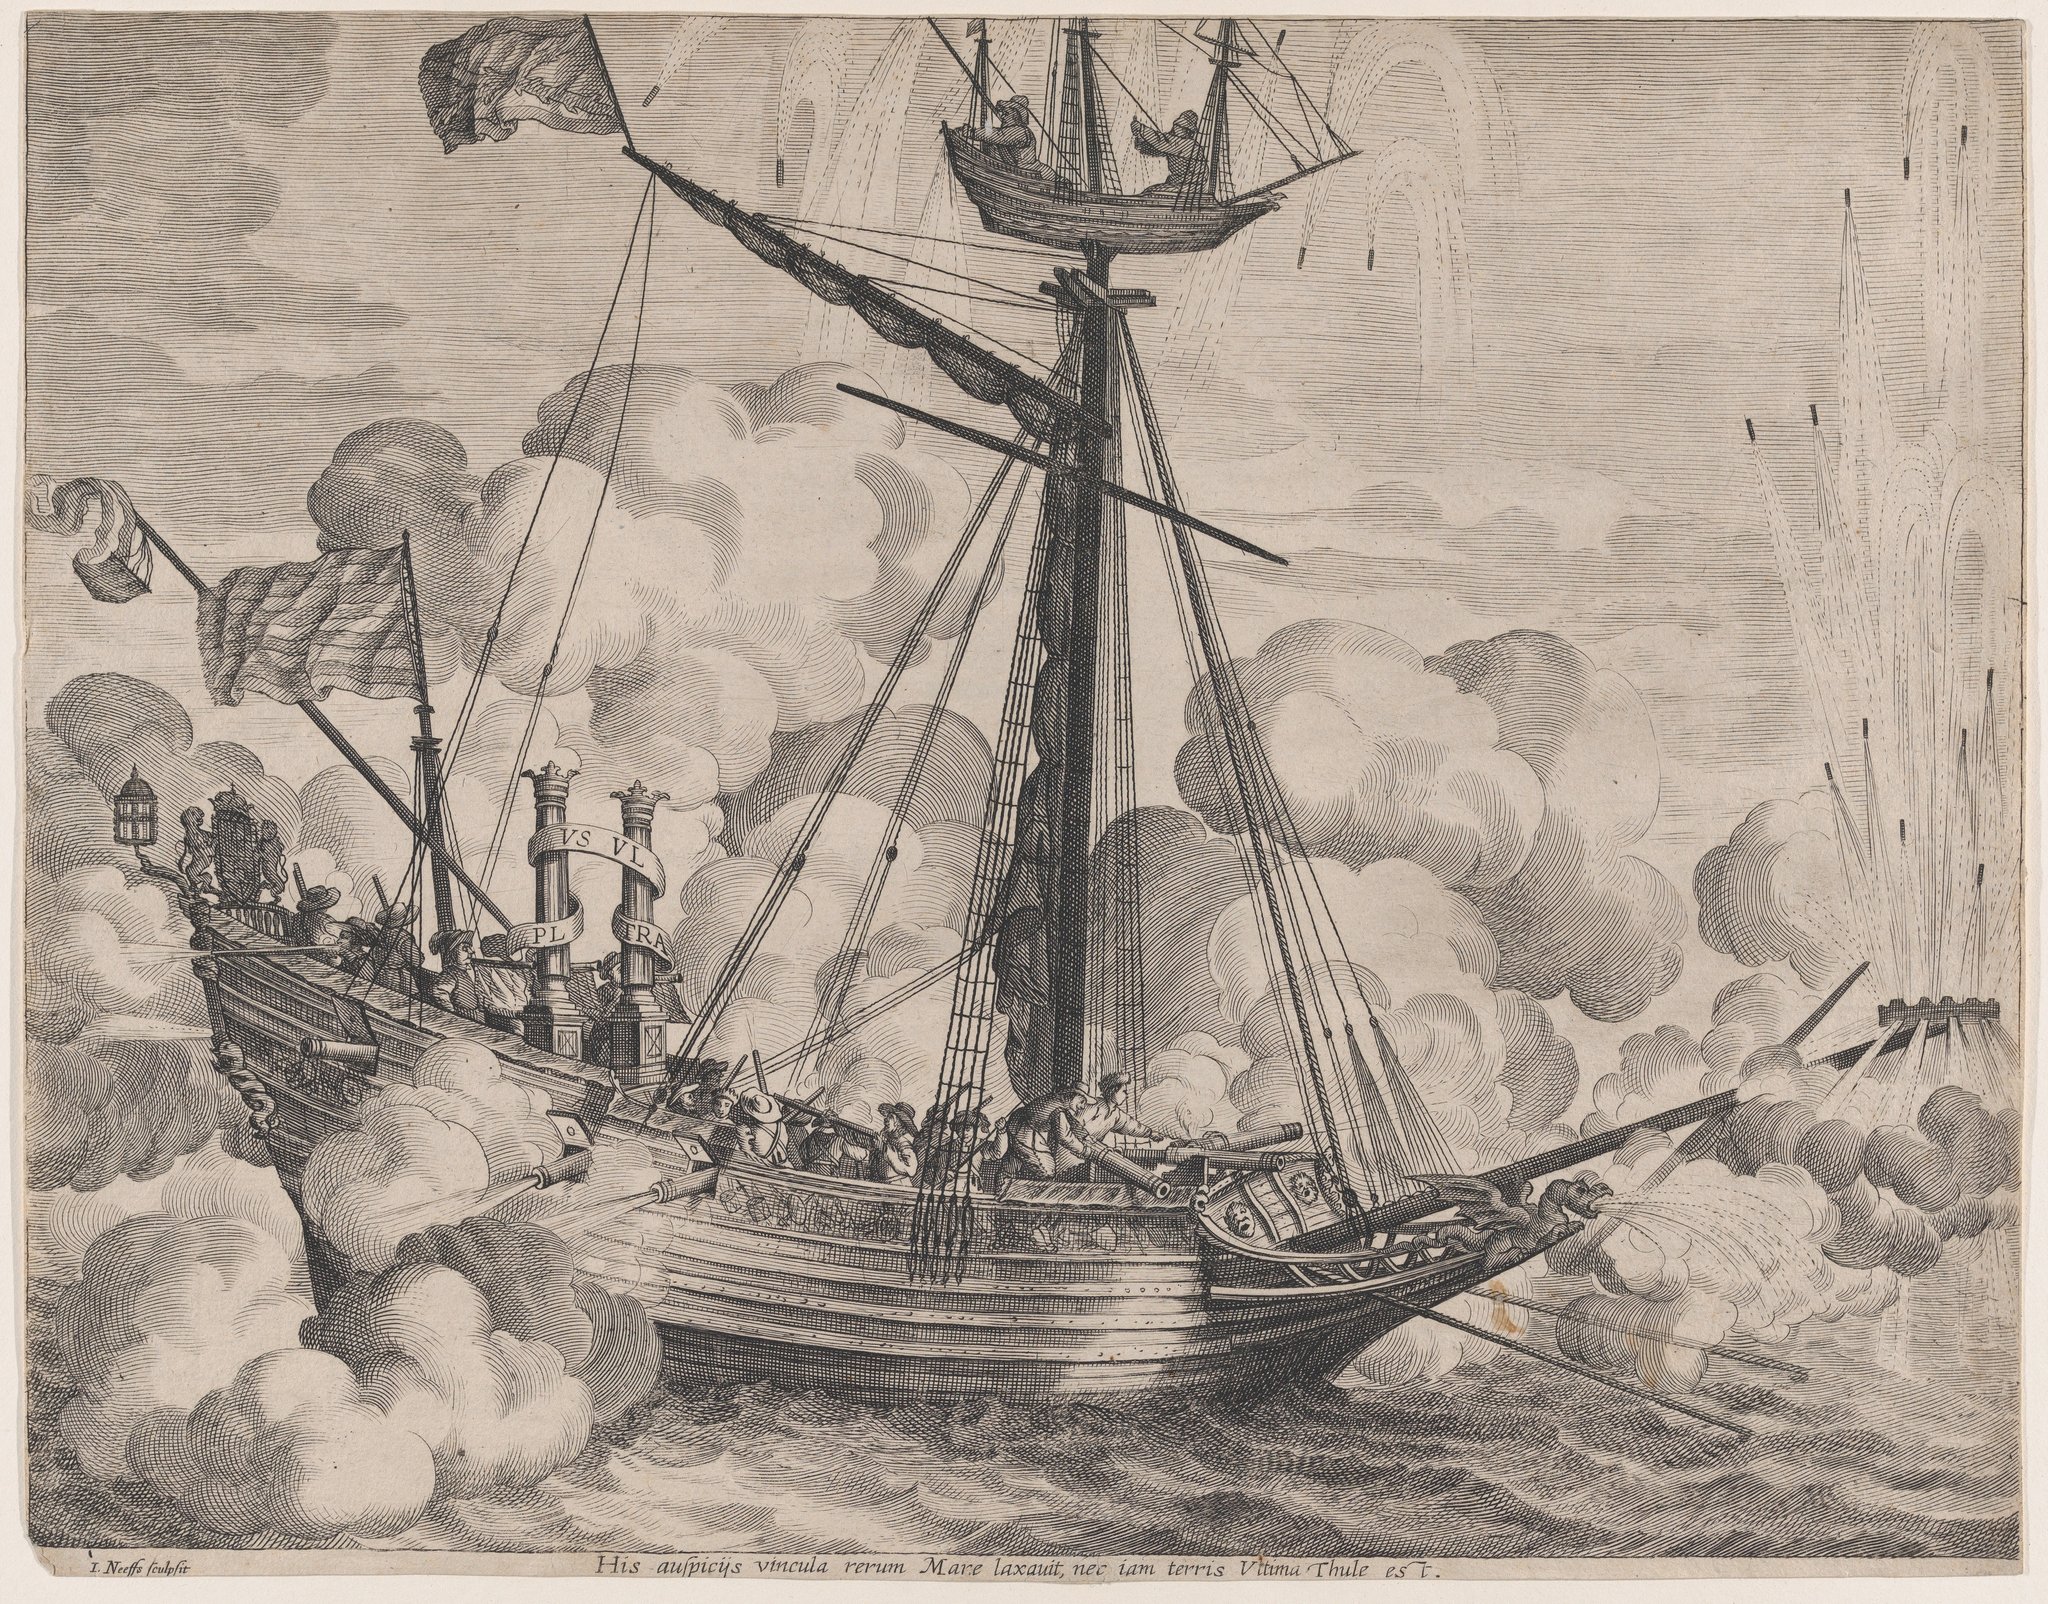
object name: print, fete, ornament architecture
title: Plate 37: Triumphal ship with fireworks display to the right; from Guillielmus Becanus's 'Serenissimi Principis Ferdinandi, Hispaniarum Infantis...'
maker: jacob neeffs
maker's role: artist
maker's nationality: flemish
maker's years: 1610-1670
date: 1636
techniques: engraving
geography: antwerp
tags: cannons,ships